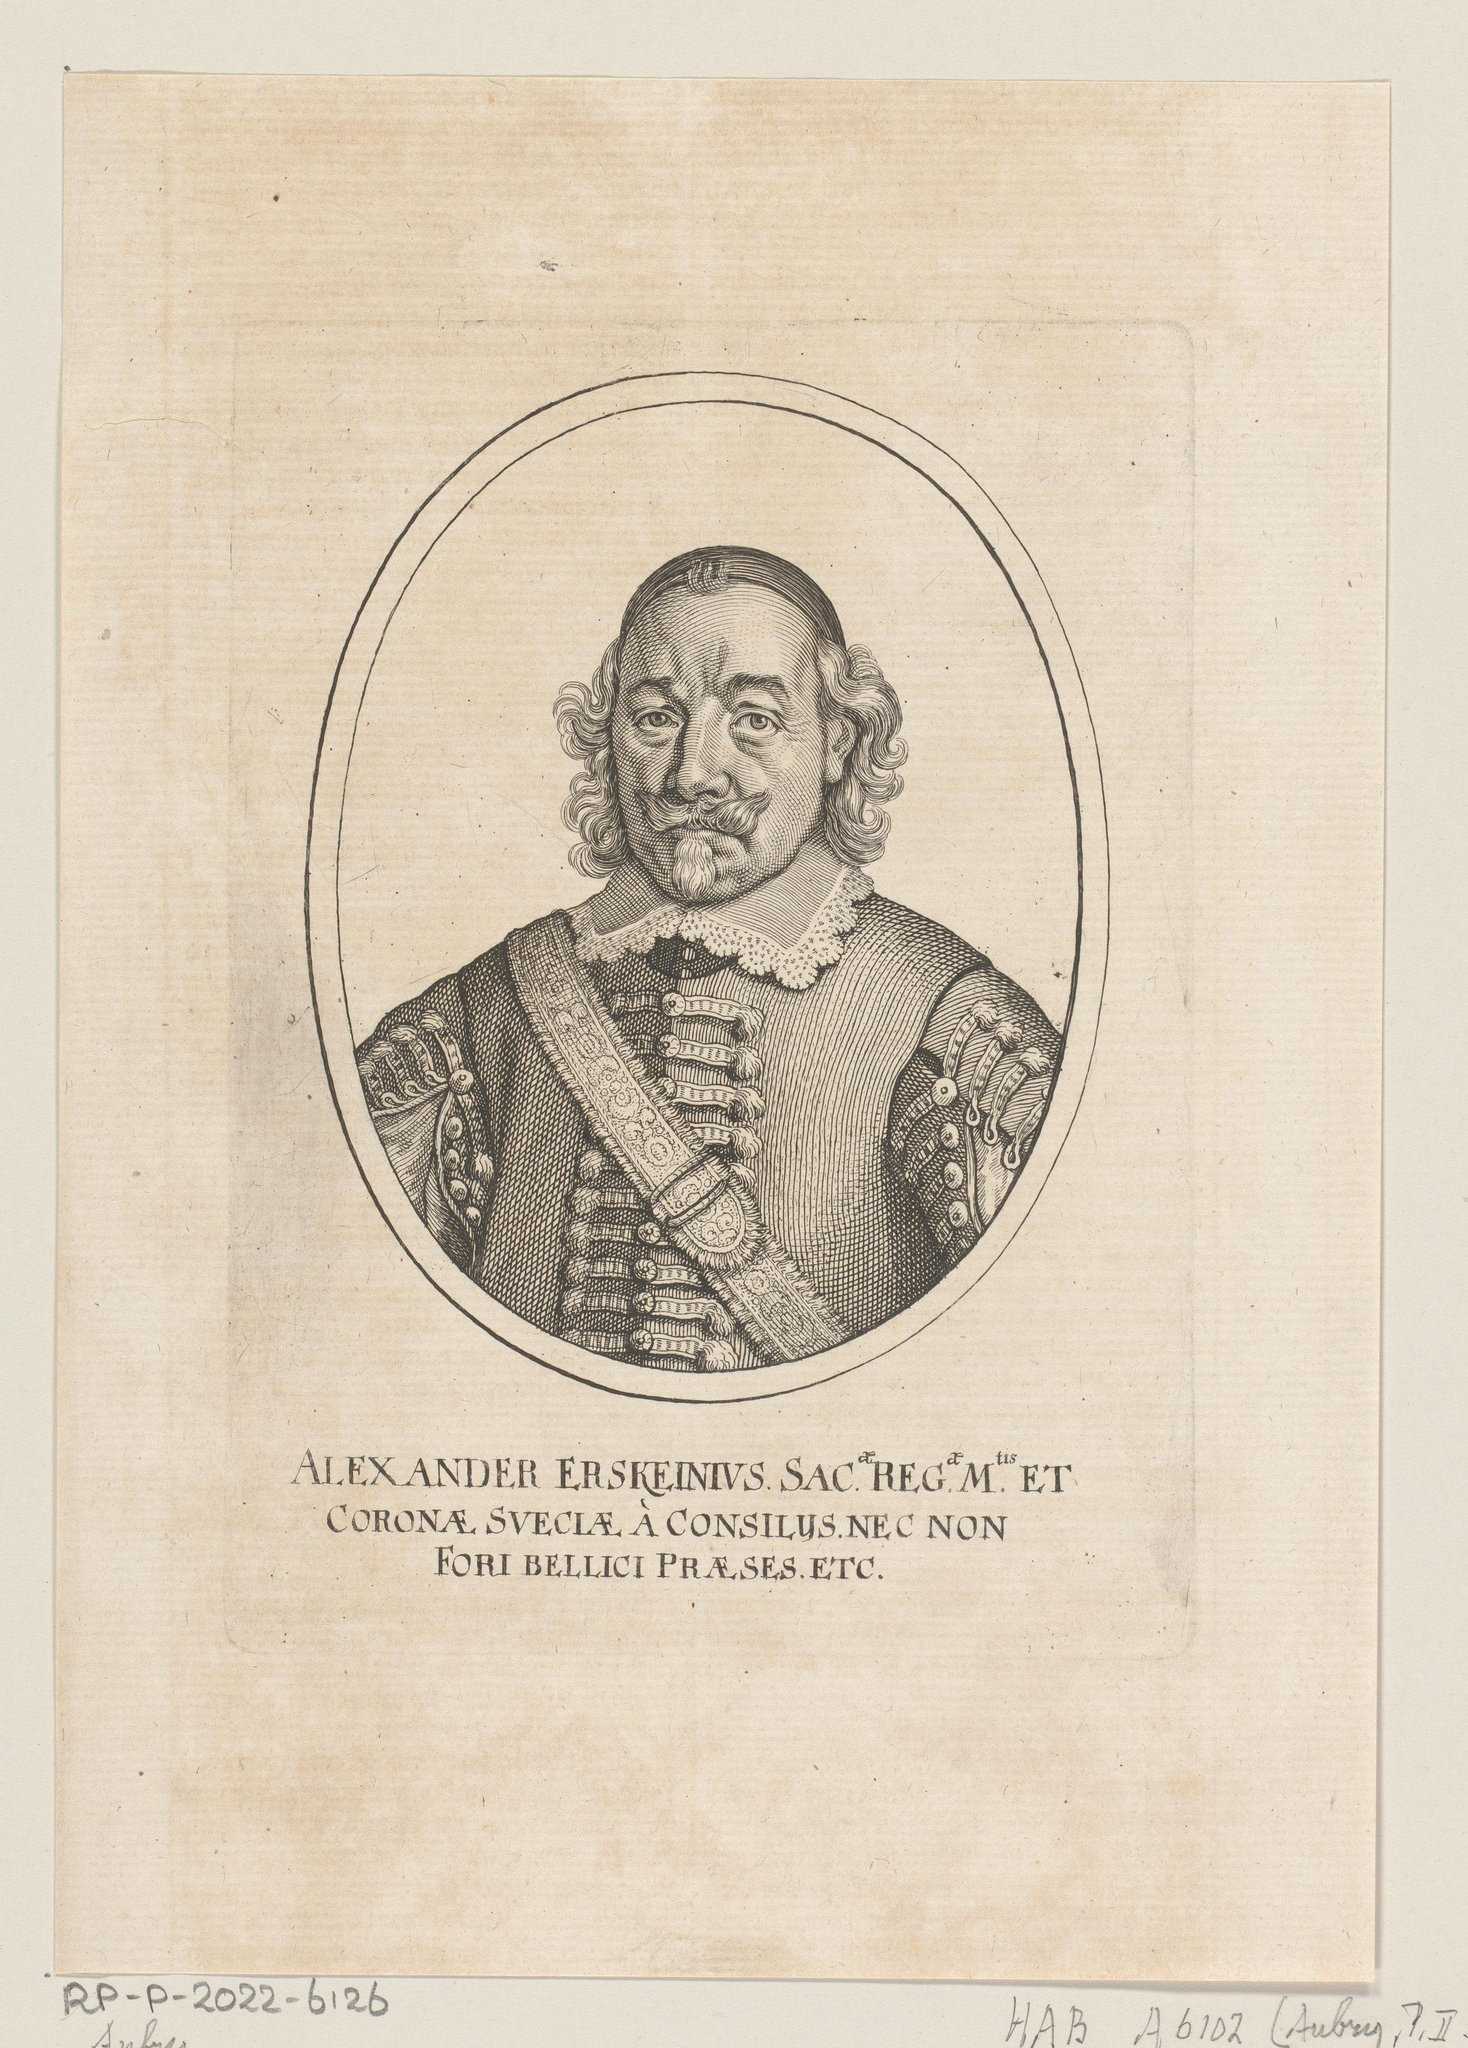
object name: print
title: Portret van Alexander Erskein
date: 1652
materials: paper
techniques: engraving, etching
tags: historical persons, diplomacy, diplomat, magistracy, judges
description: Prent met tekst in boekdruk op recto en verso gebruikt in: Theatrum Europaeum (...). 1e druk. Frankfurt: erven Matthaus Merian, 1652, dl. 6. Mogelijk ook gebruikt in een latere druk van dit werk.